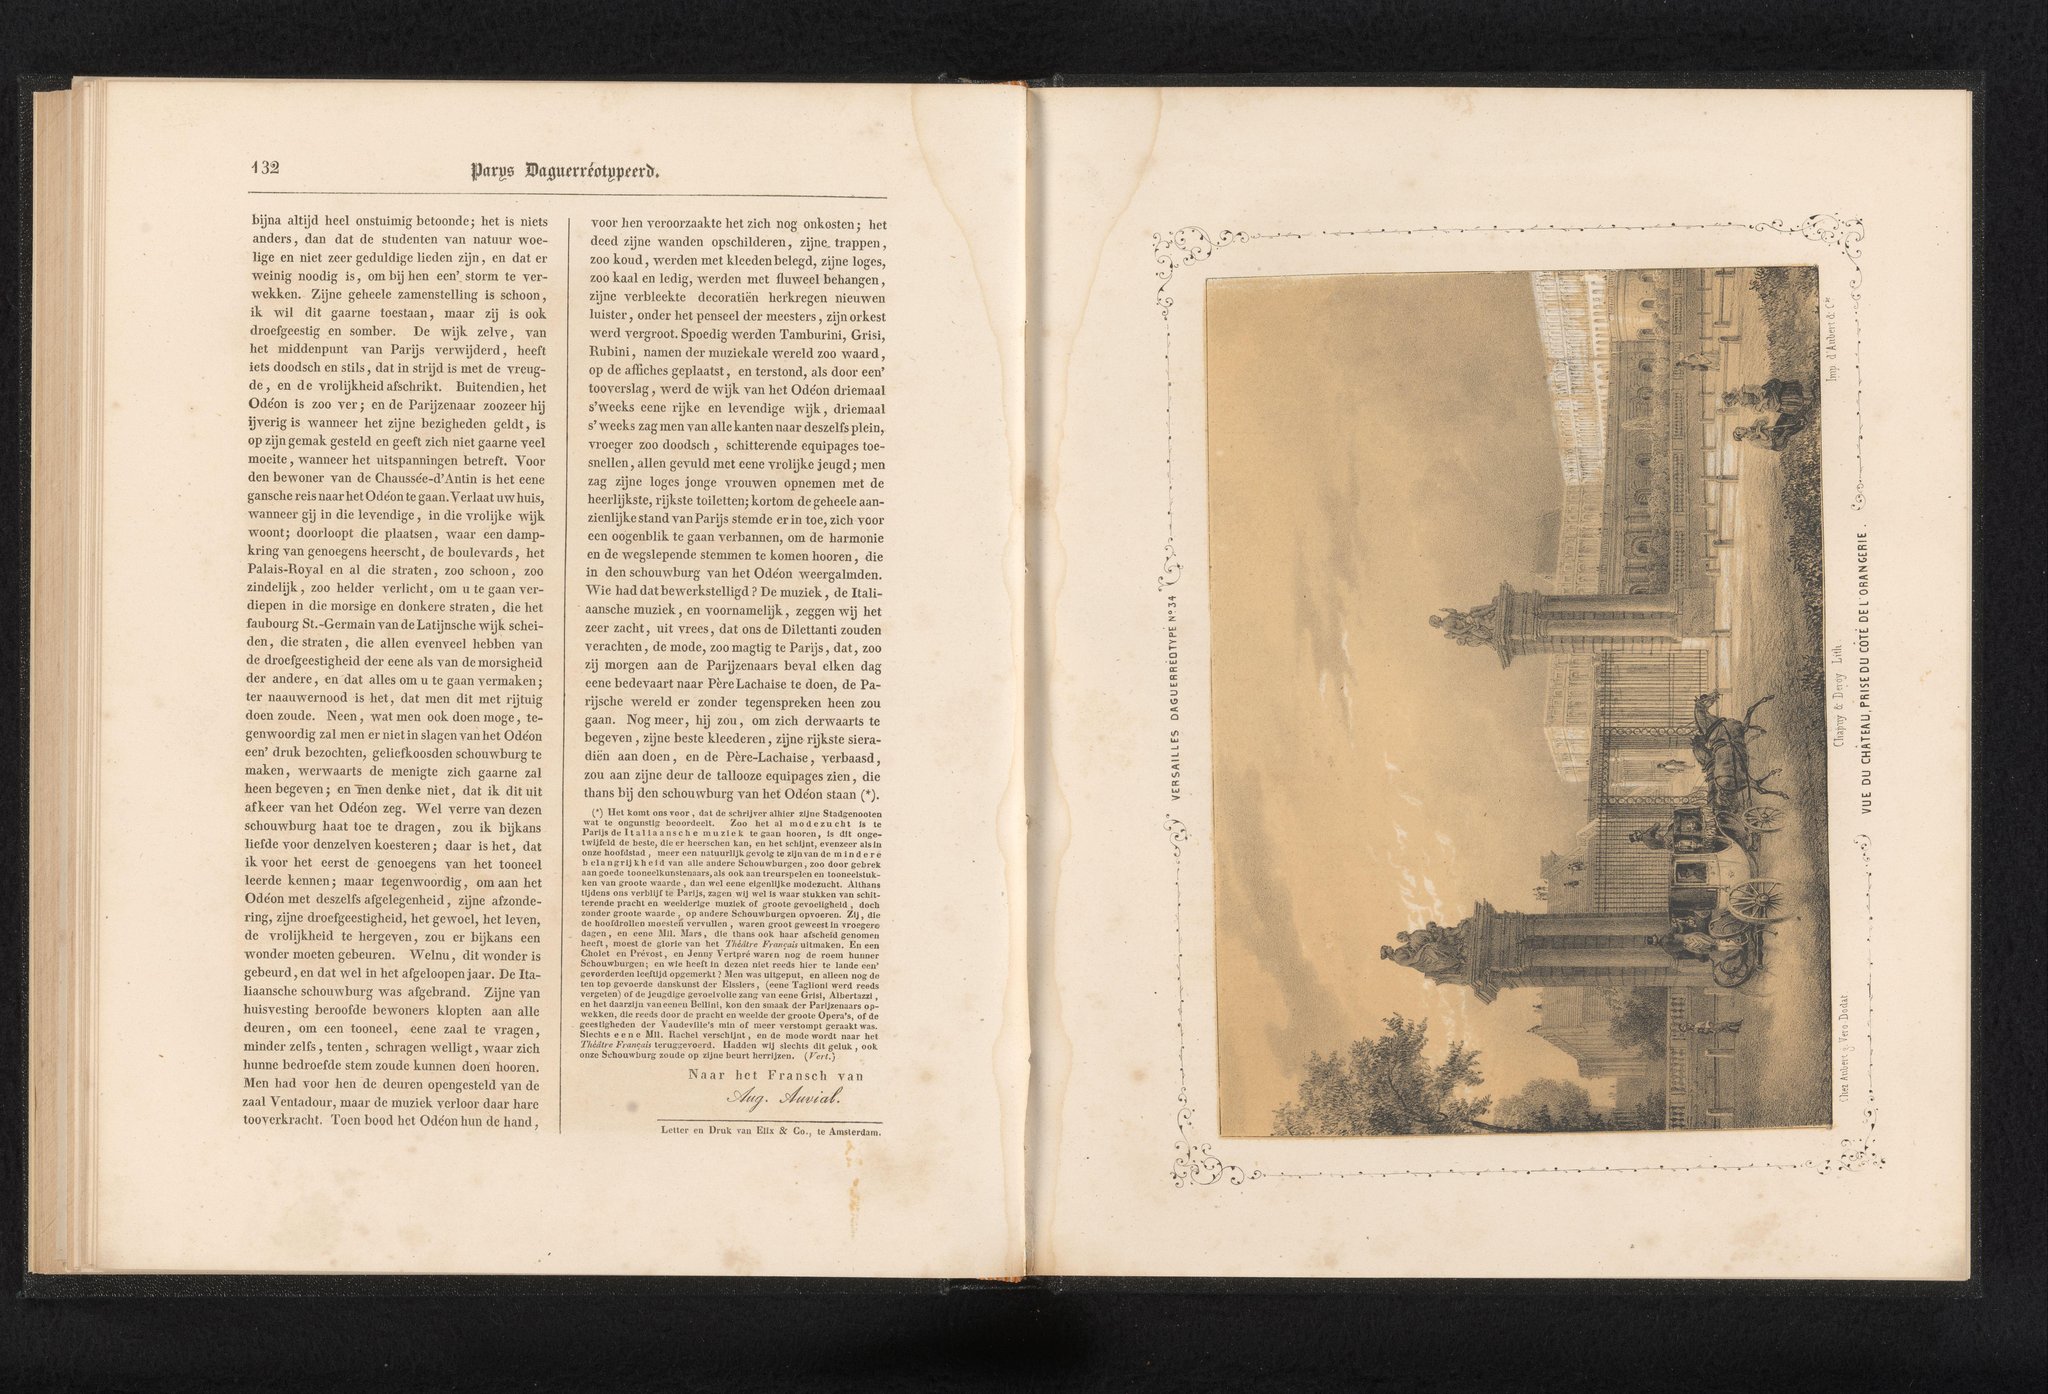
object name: page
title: Vue du Château, prise du côté de l'orangerie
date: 1839-1840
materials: paper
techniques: tone lithography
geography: paris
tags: palace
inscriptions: inscription: ‘VERSAILLES DAGUERRÉOTYPÉ No. 34.’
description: Prent op honderdvijfendertigste ongenummerde pagina.